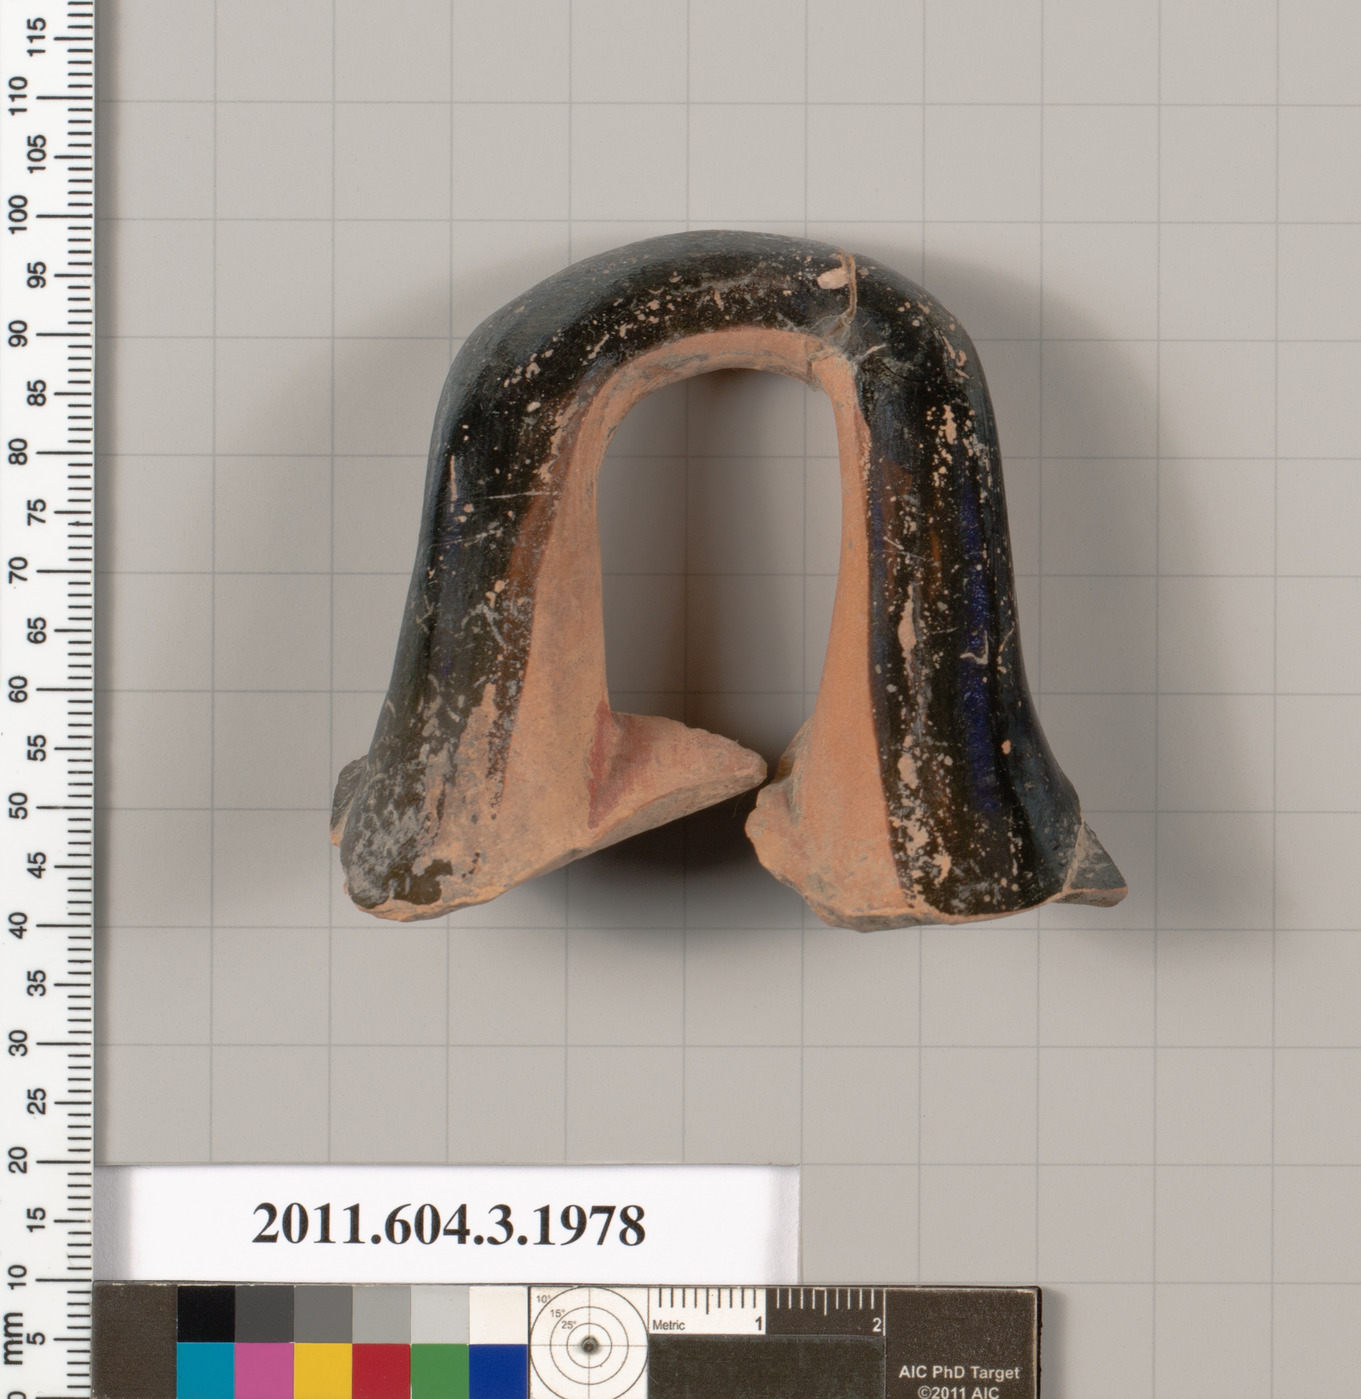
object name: kylix fragment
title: Terracotta fragment of a kylix (drinking cup)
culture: greek, attic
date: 600-401 BCE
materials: terracotta